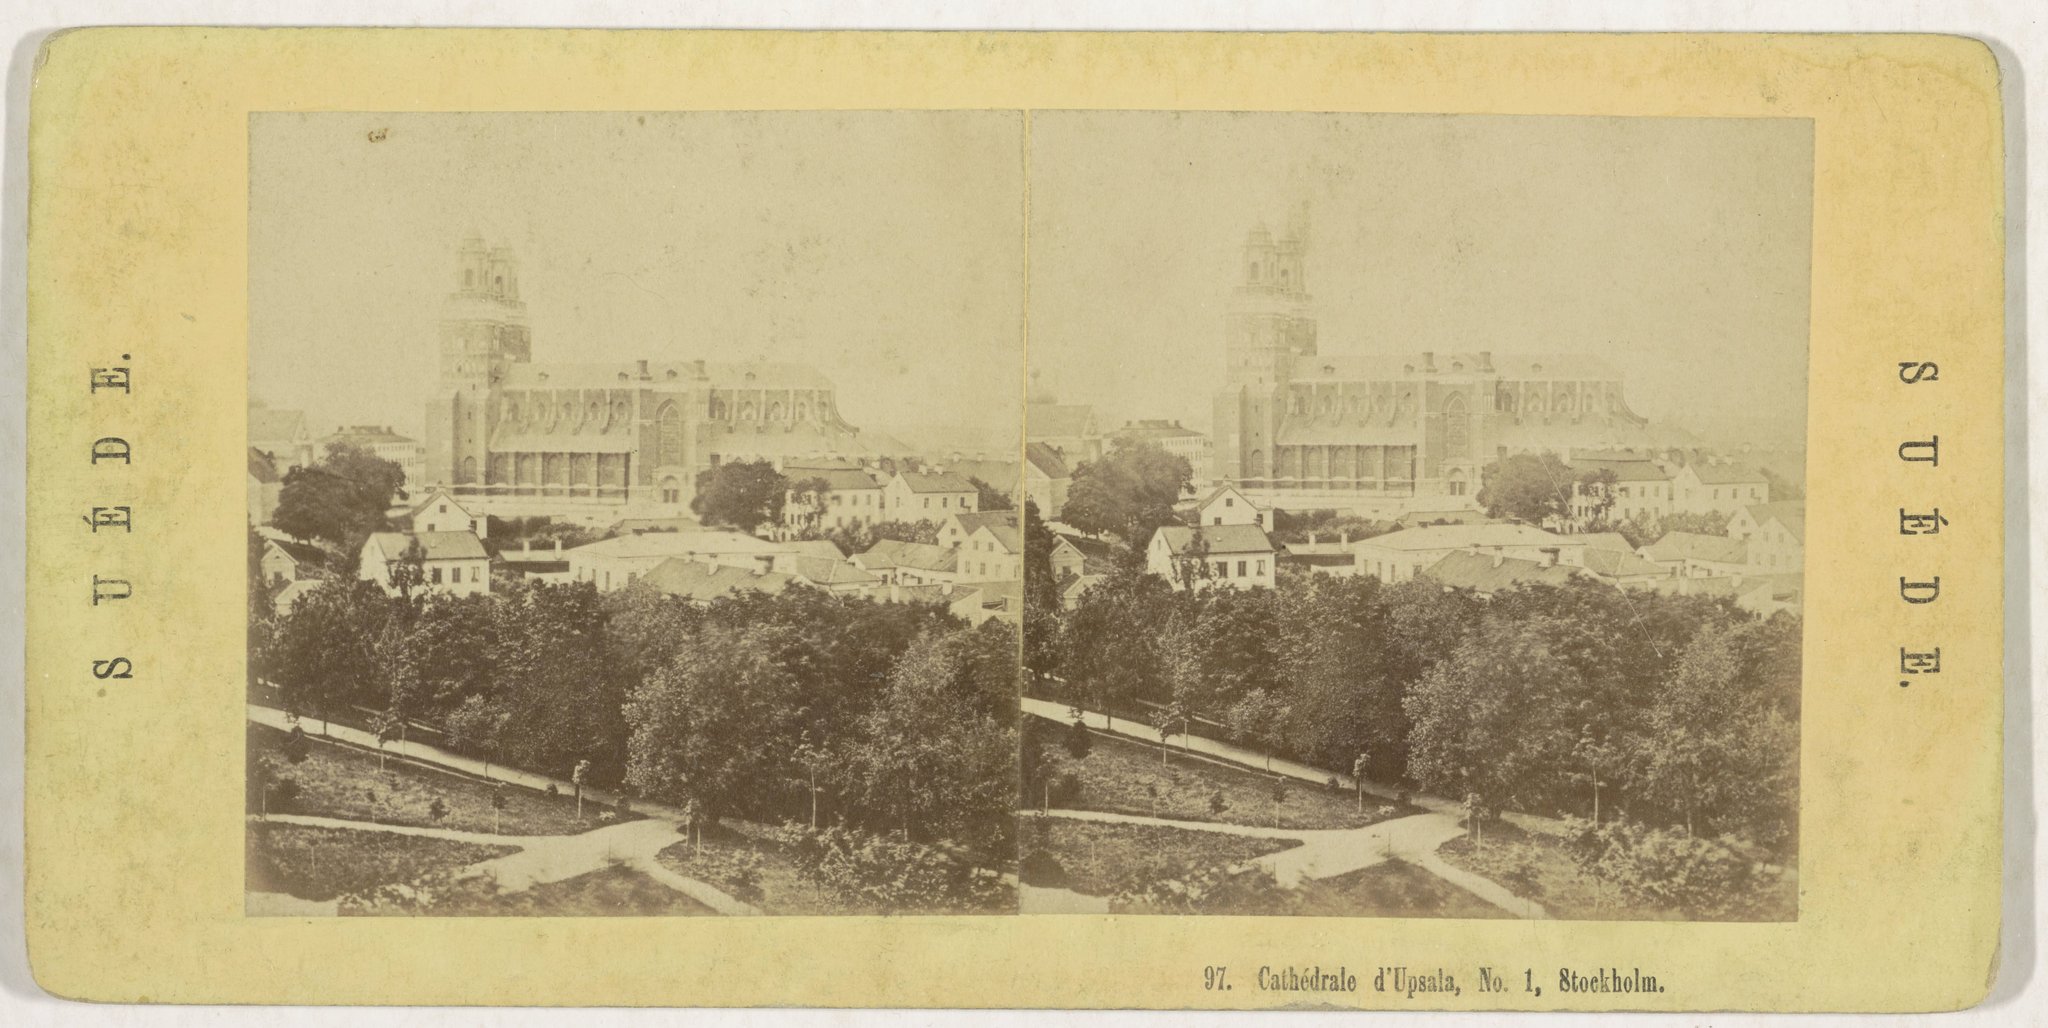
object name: stereograph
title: Kathedraal van Uppsala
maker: Anonymous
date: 1868-1890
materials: cardboard, paper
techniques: albumen print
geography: uppsala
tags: church (exterior)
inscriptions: number: ‘97’